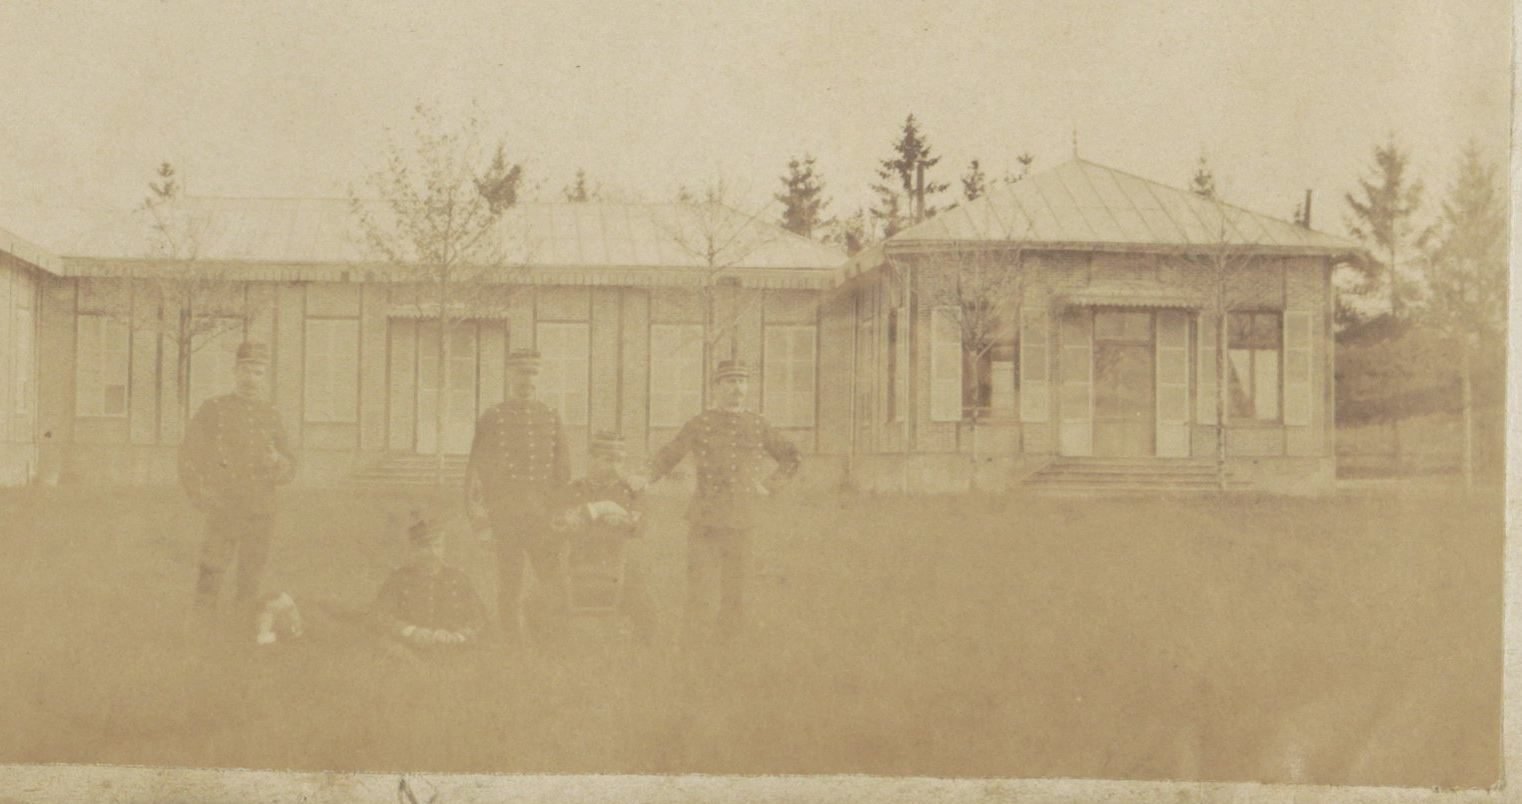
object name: photograph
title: Vijf Franse militairen poserend voor een gebouw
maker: Anonymous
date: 1805-1884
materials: photographic support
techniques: albumen print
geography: france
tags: land forces, france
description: Onderdeel van Album van een Franse amateurfotograaf met opnames van familie, militairen, industrie, landschappen en bezienswaardigheden in Frankrijk.